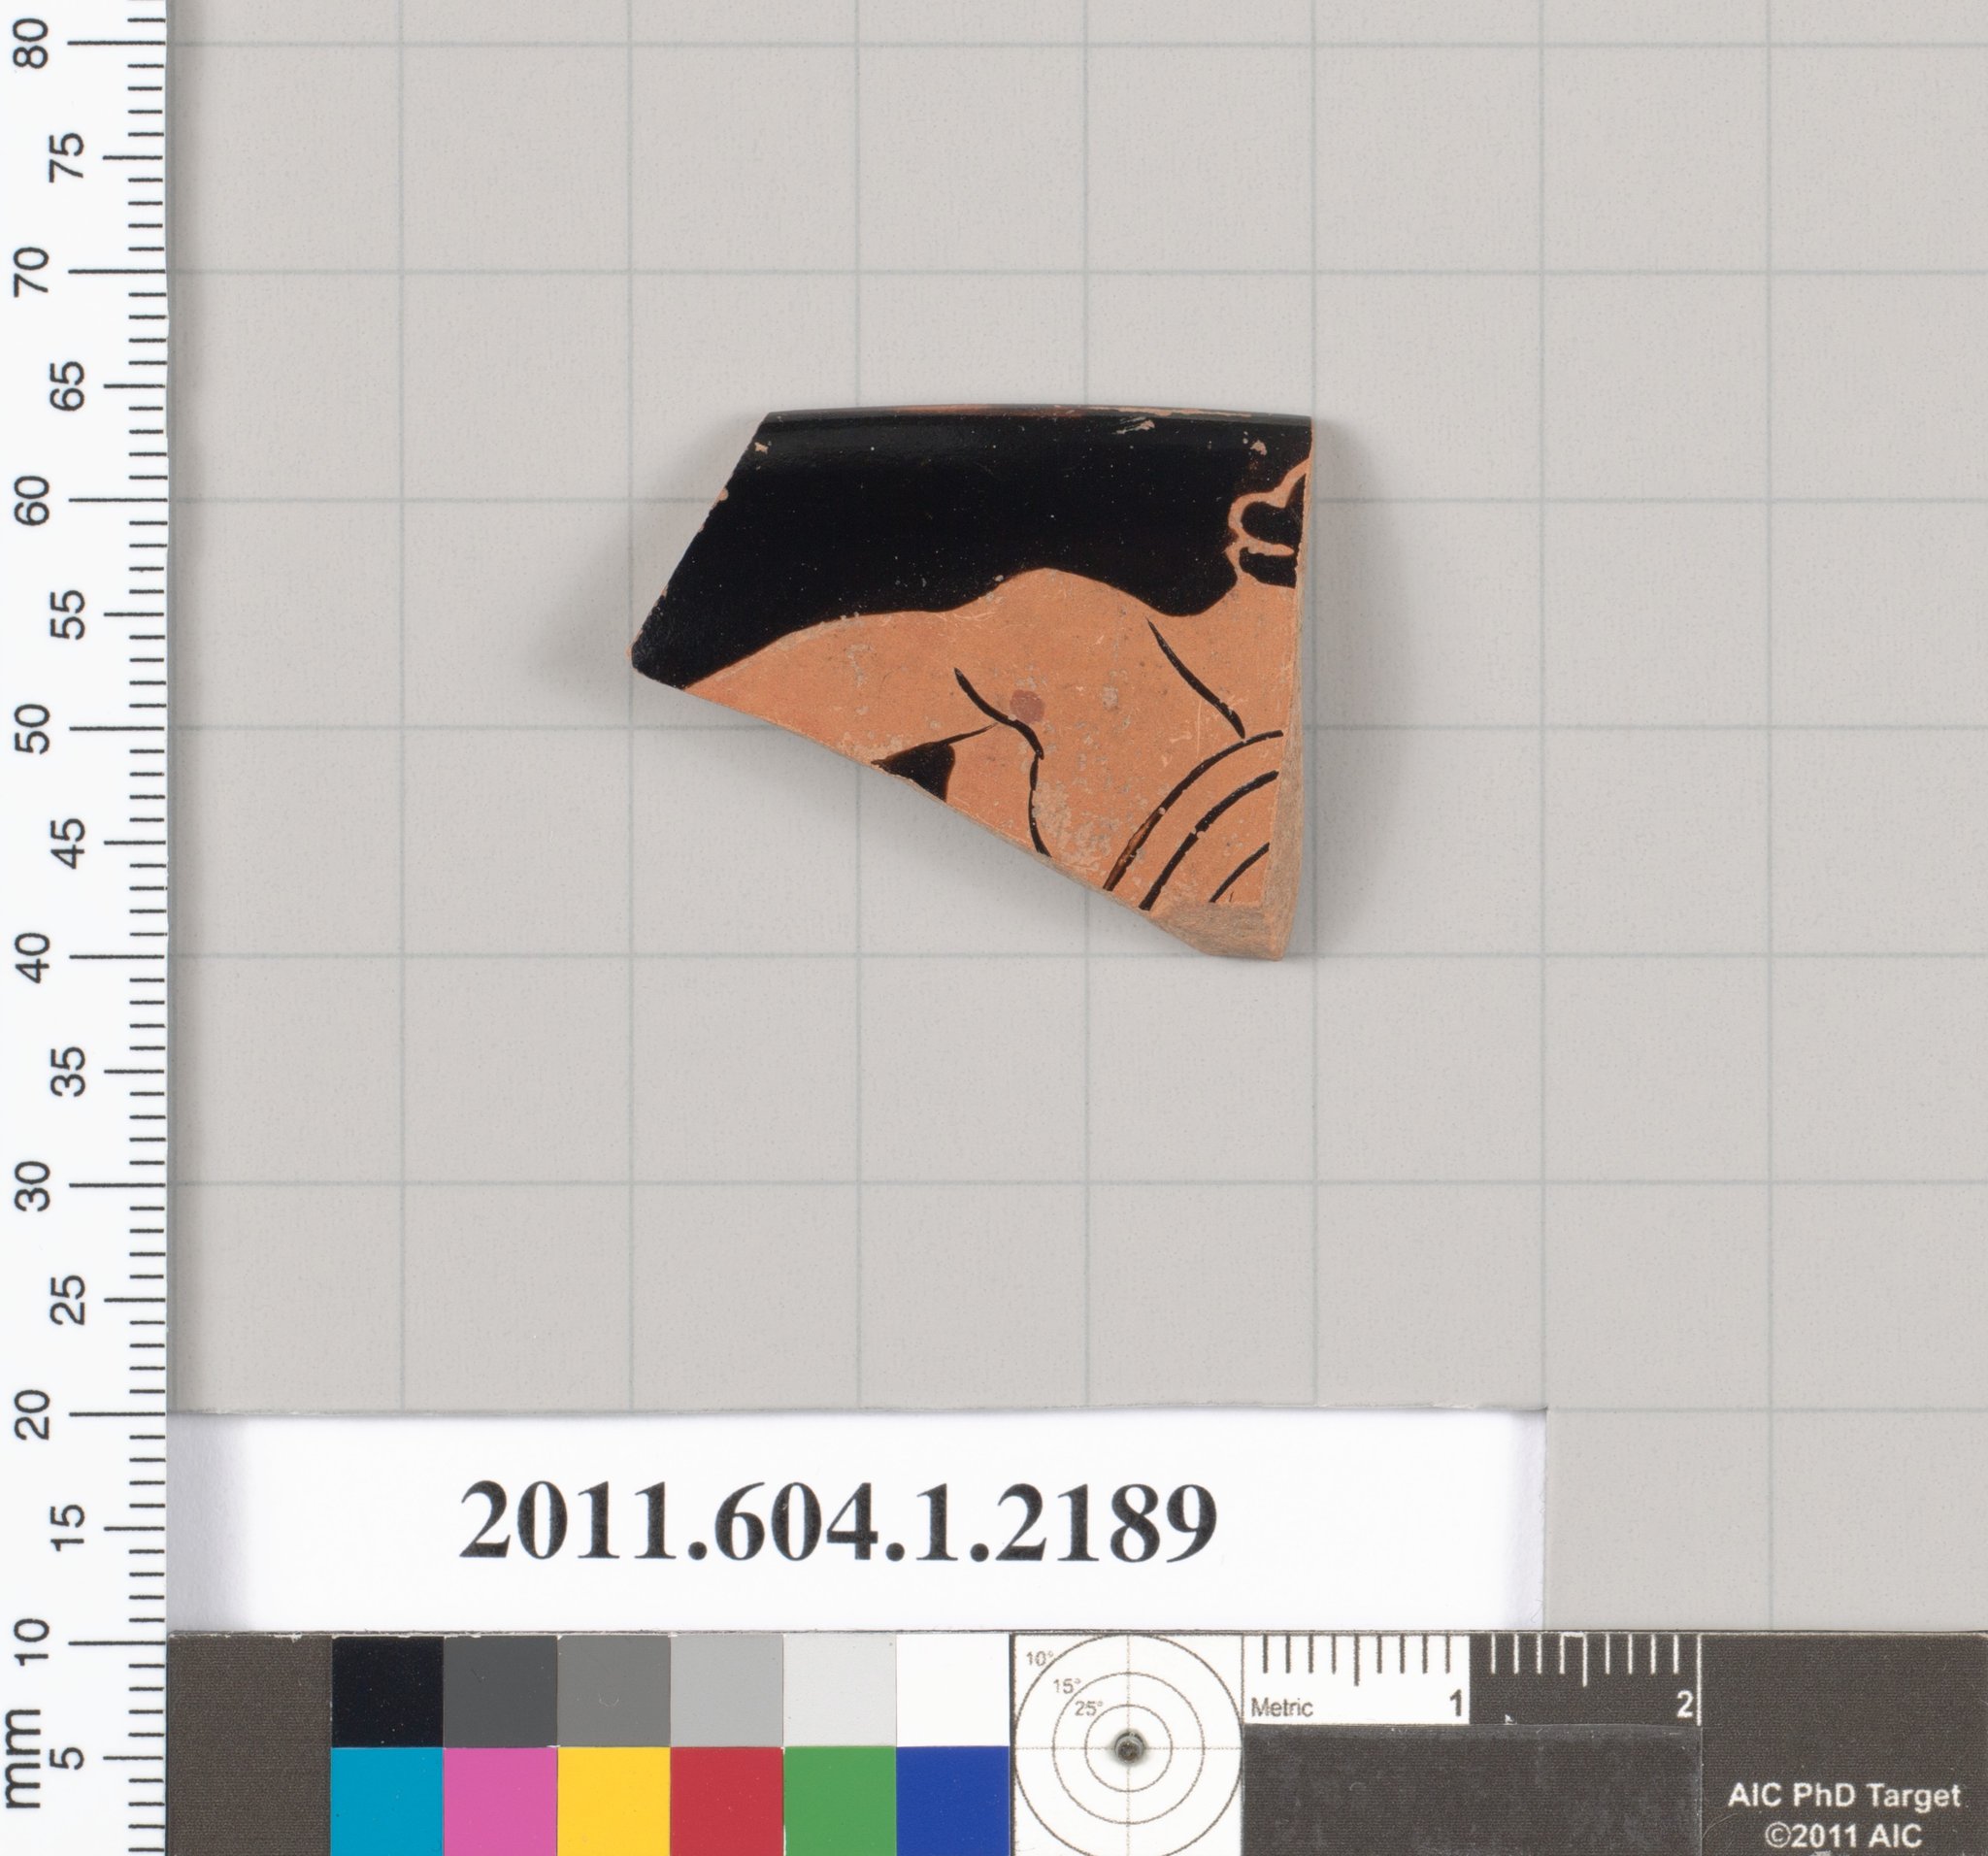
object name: kylix fragment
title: Terracotta rim fragment of a kylix (drinking cup)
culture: greek, attic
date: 490-480 BCE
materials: terracotta